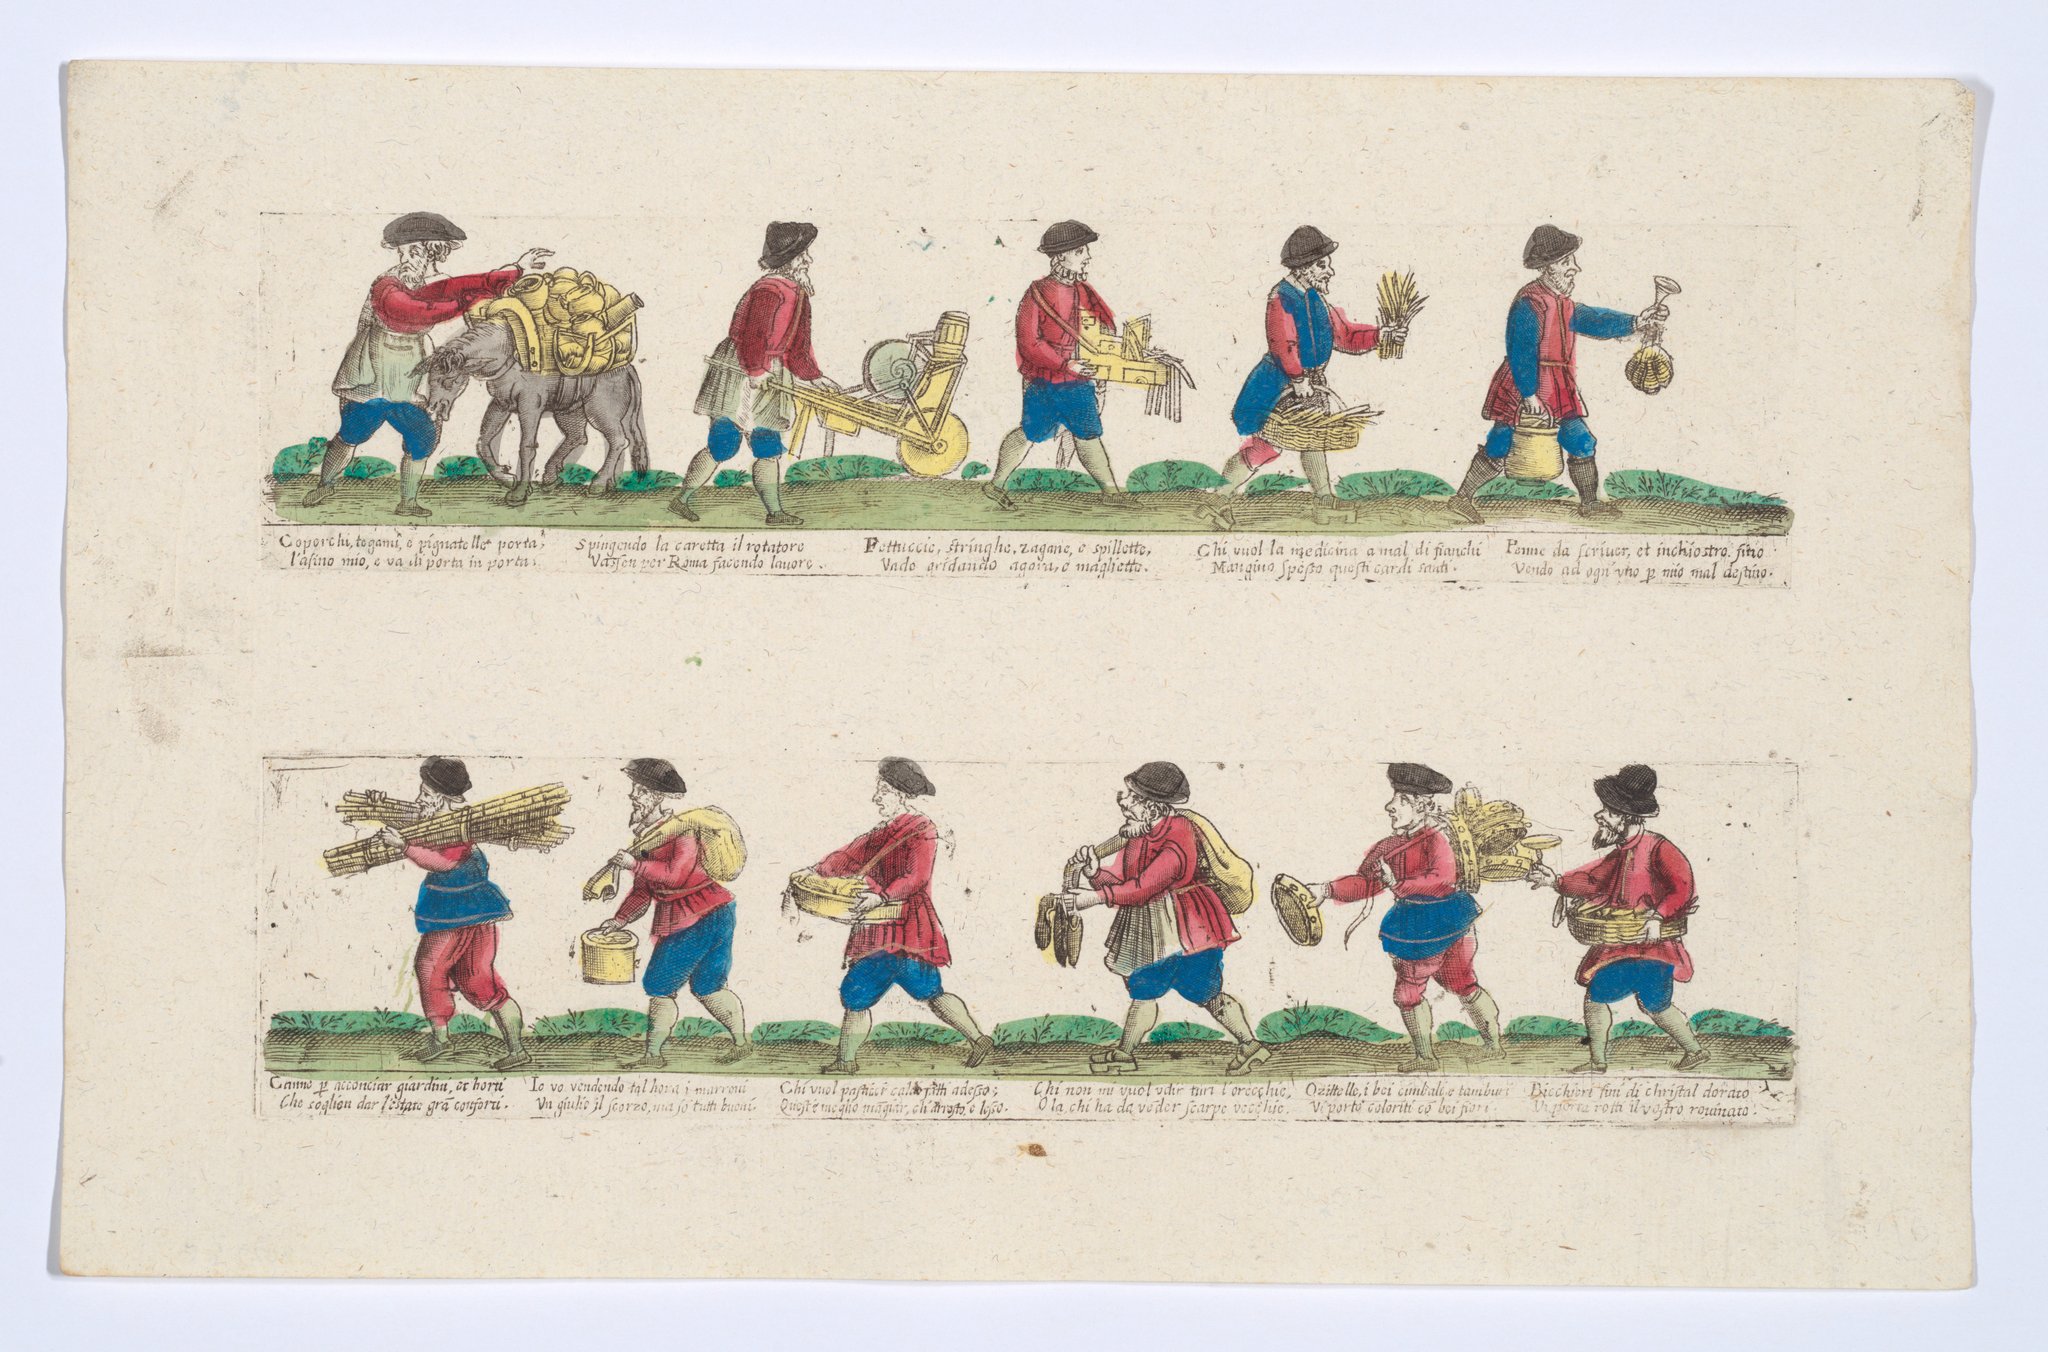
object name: print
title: Unnumbered plate depicting the trades of Rome, here including vendors of kitchen pots, garden stakes, cups etc, from the 'Descrición de las artes que se llaman para los calles de la ciudad de Roma'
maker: remondini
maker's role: publisher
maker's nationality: italian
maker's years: 1650-1860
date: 1770-1800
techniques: engraving, hand coloring